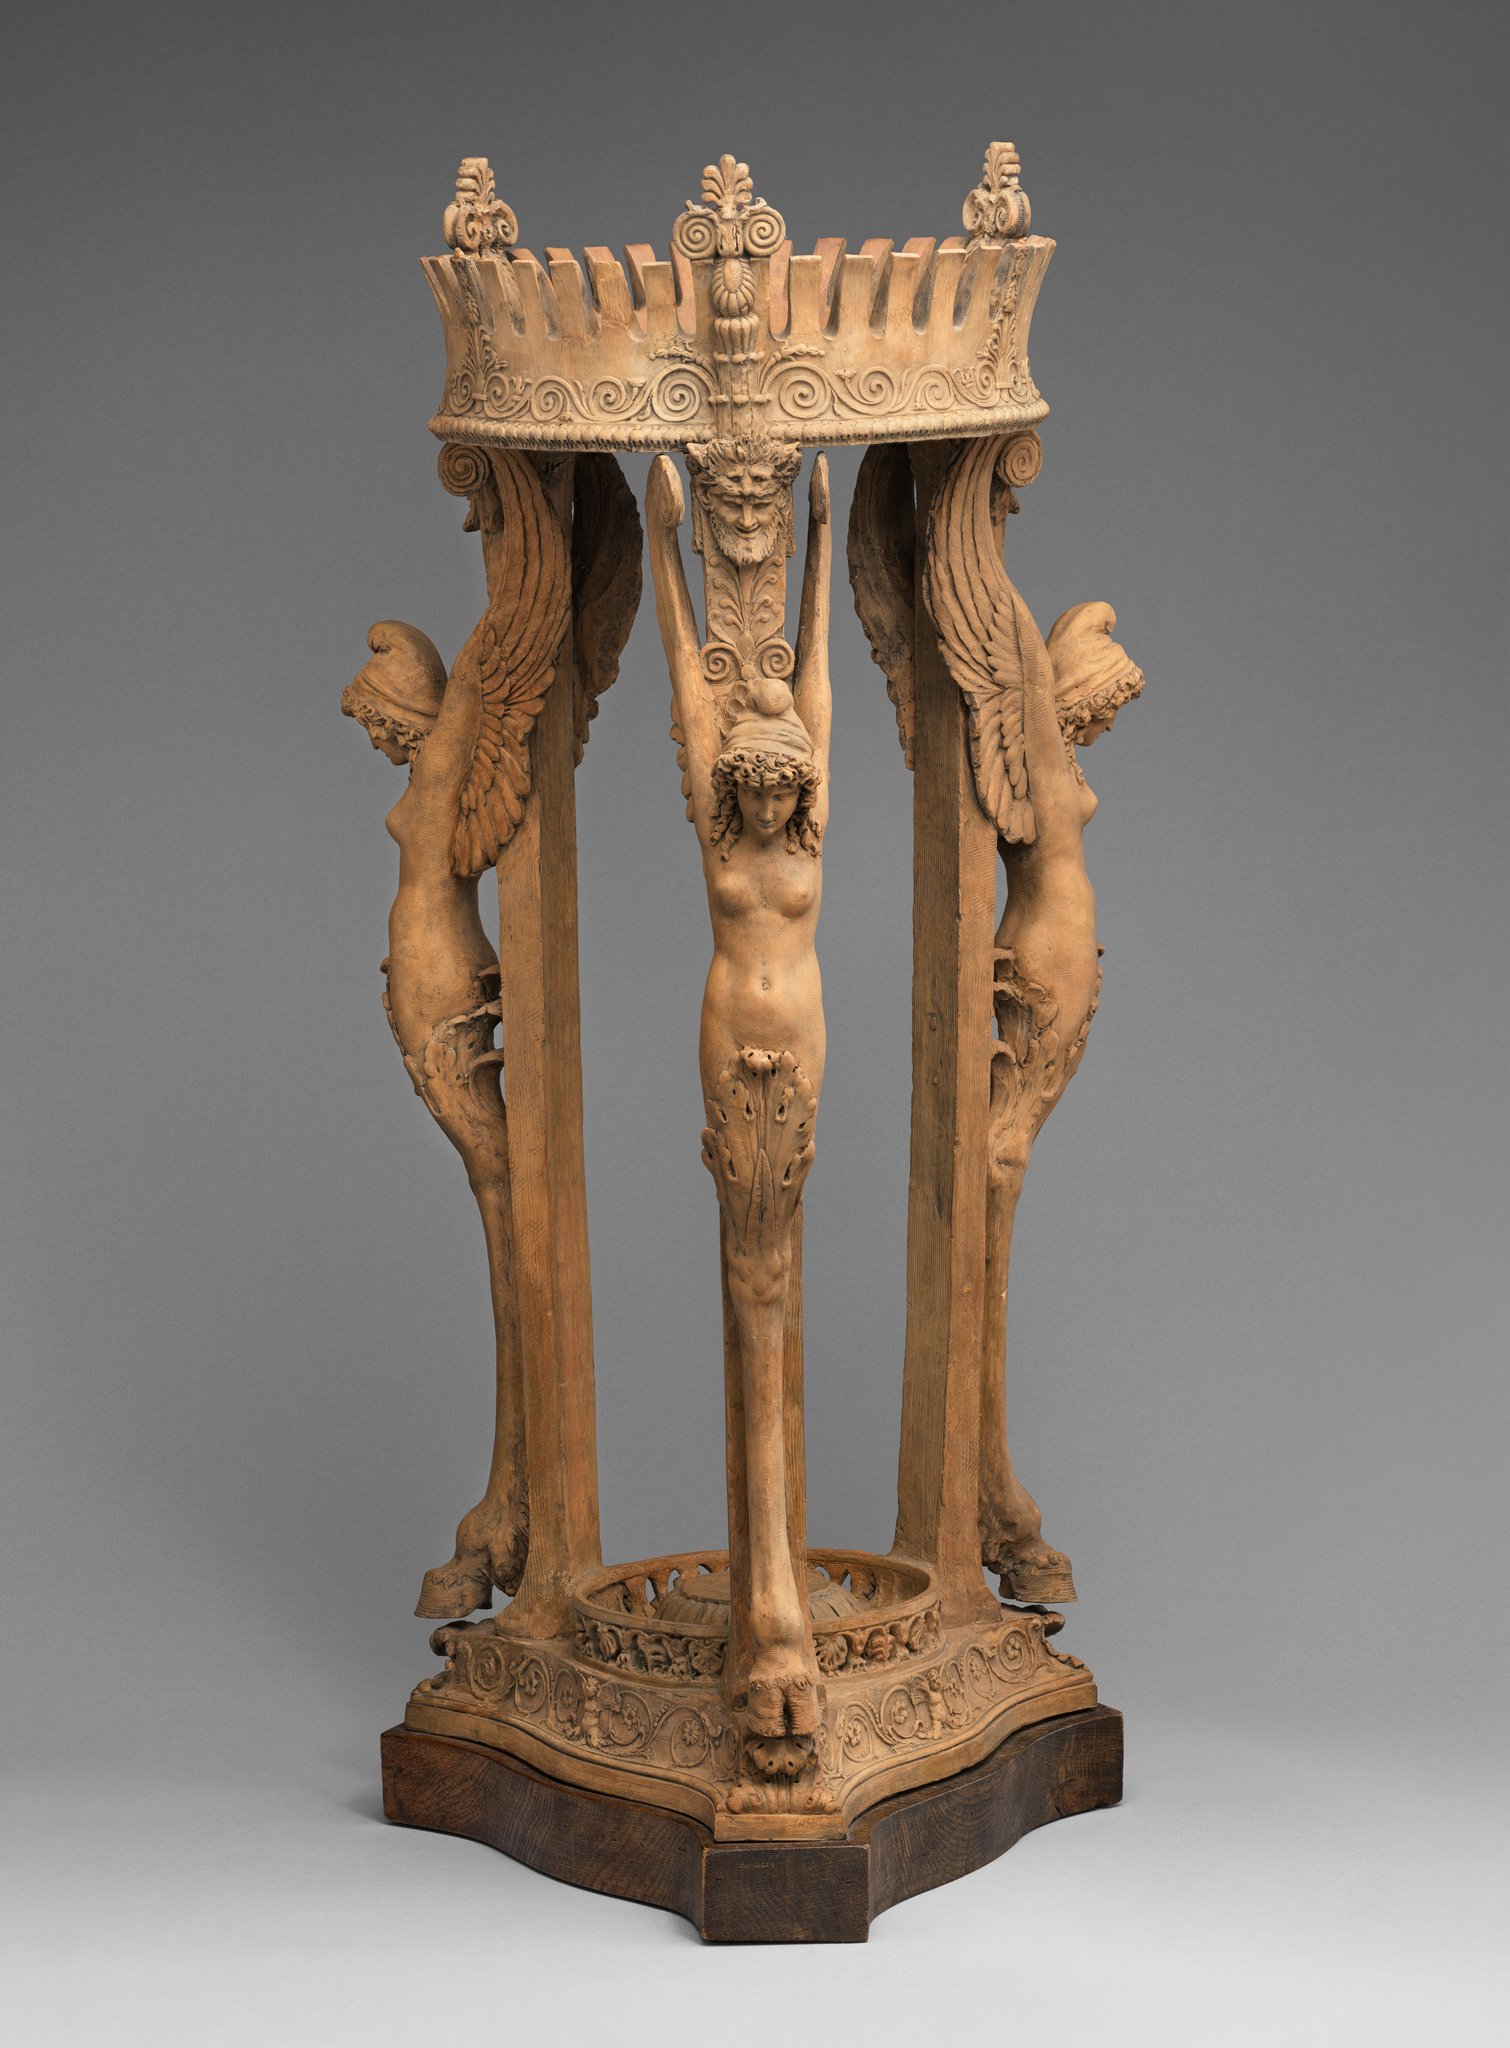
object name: tripod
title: Tripod table stand (Athénienne)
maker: joseph chinard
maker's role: artist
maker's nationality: french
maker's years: 1756-1813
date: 1793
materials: terracotta